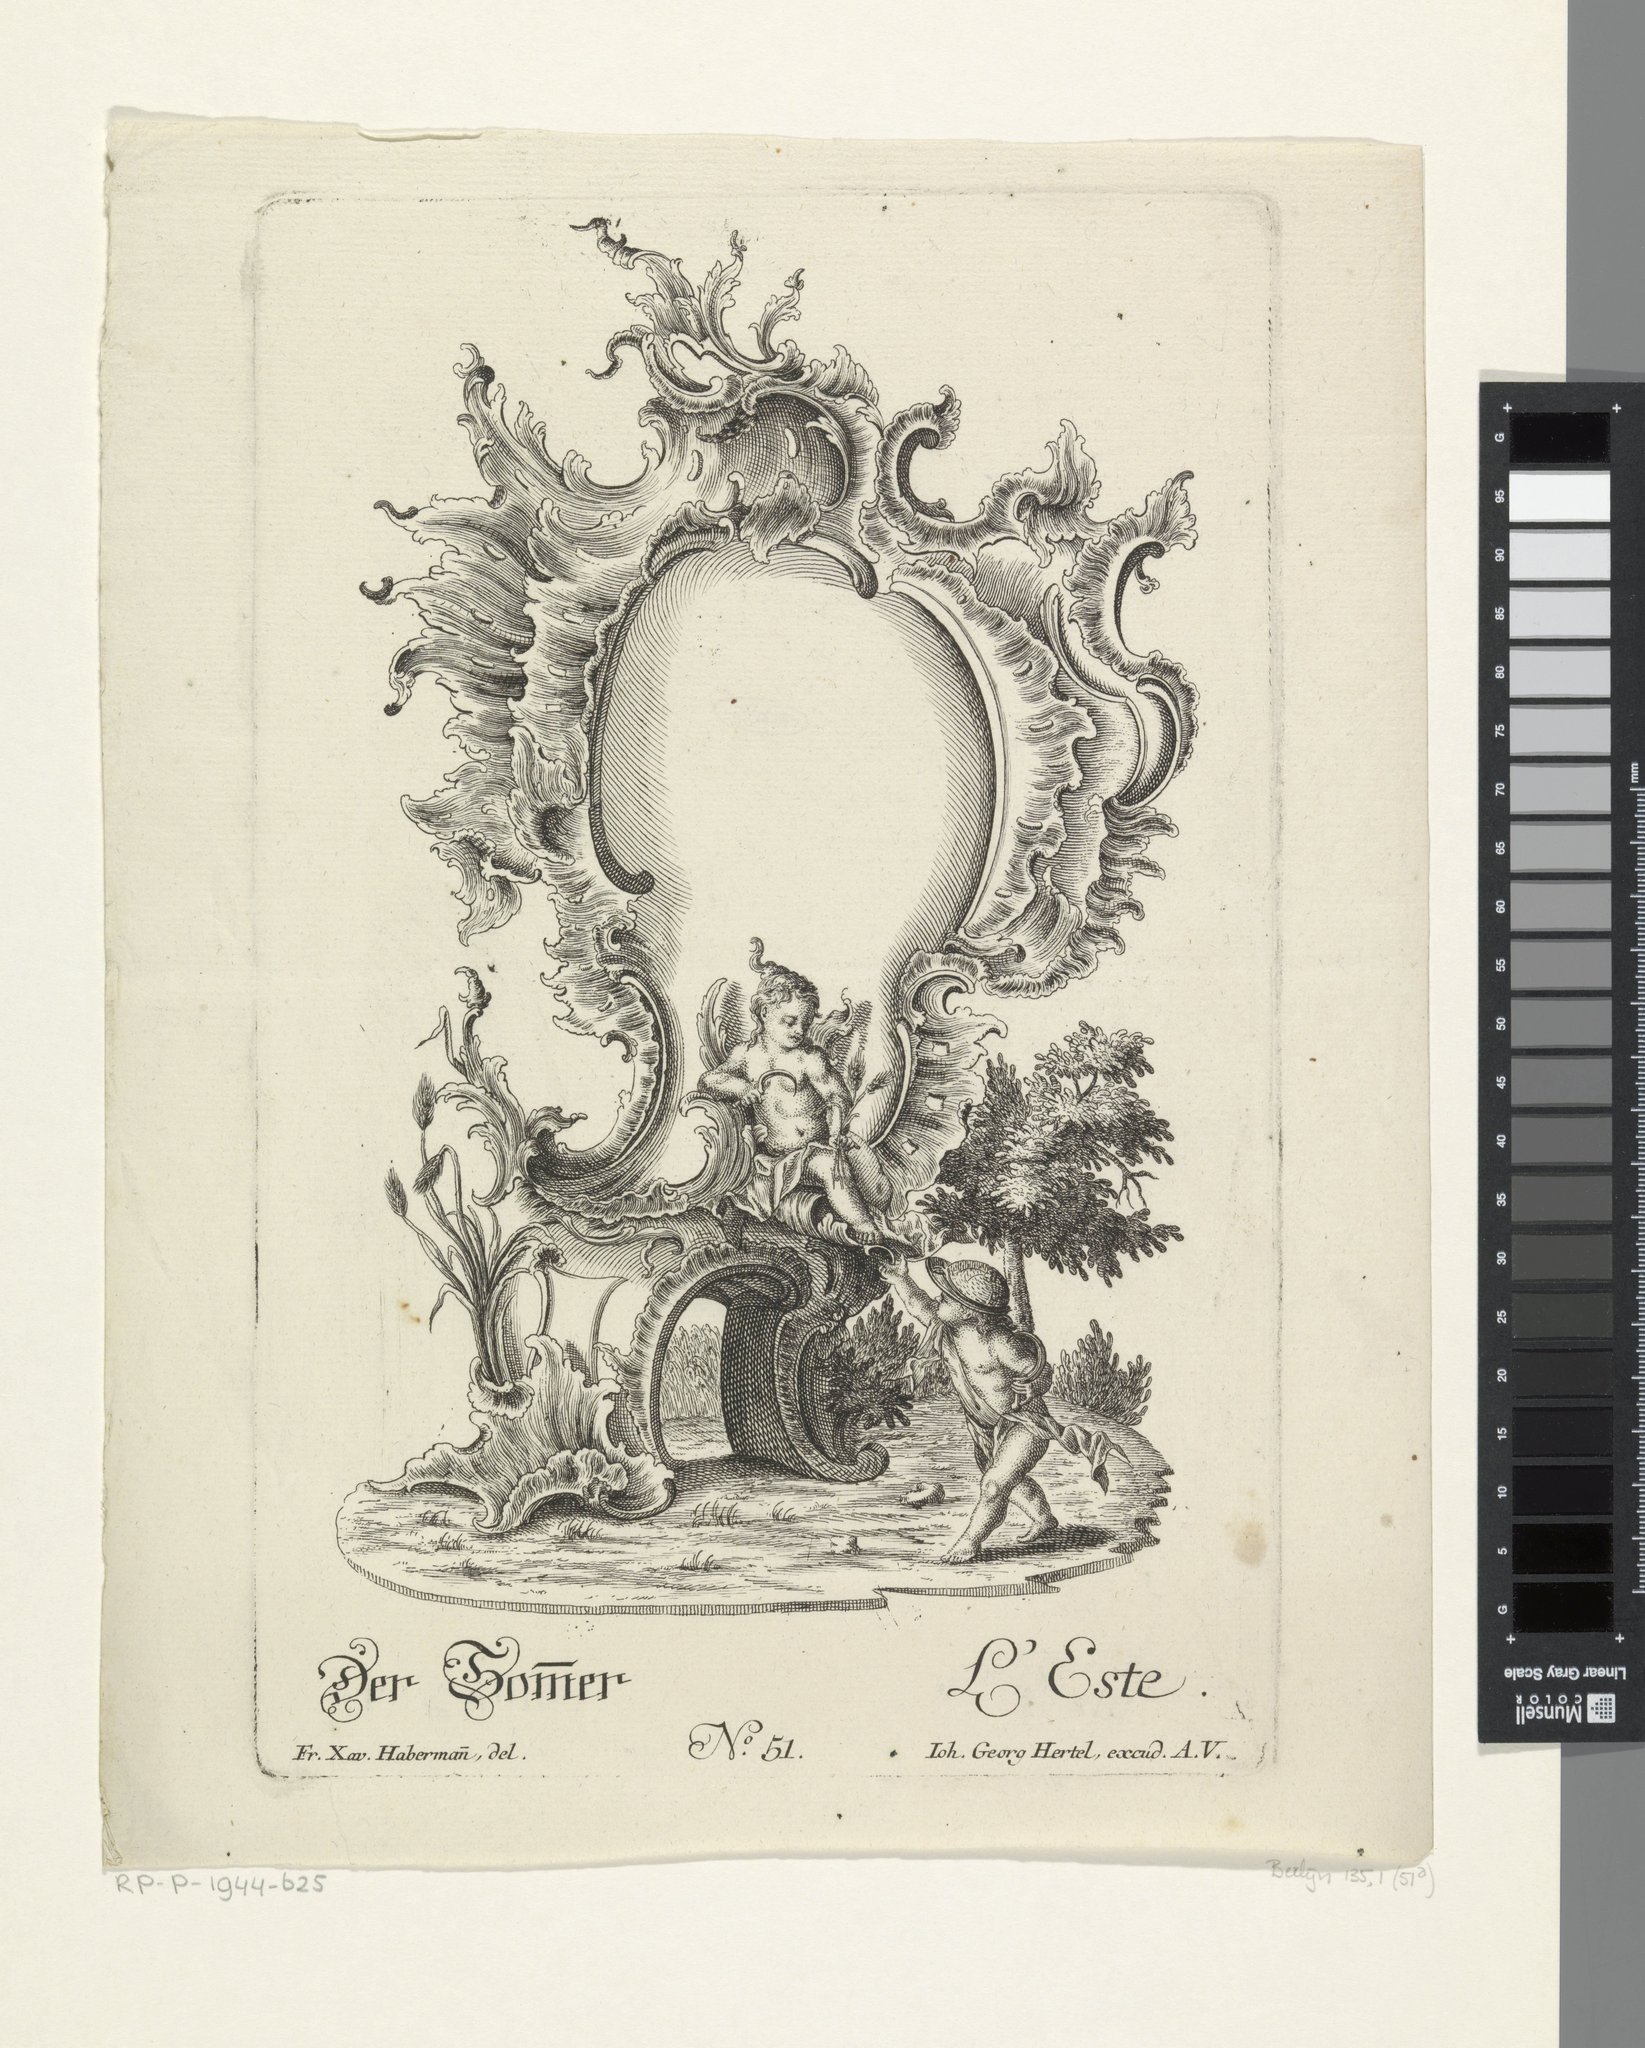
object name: print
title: Der Somer / L'Este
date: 1731-1775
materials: paper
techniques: etching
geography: augsburg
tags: rocaille ornament, summer, 'aestas'; 'estate' (ripa), ornament ~ cartouche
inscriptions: collector's mark: Lugt 2228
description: Rocaille cartouche en twee putti met graan en sikkels als personificatie van de zomer. Uitgeversnummer 51.